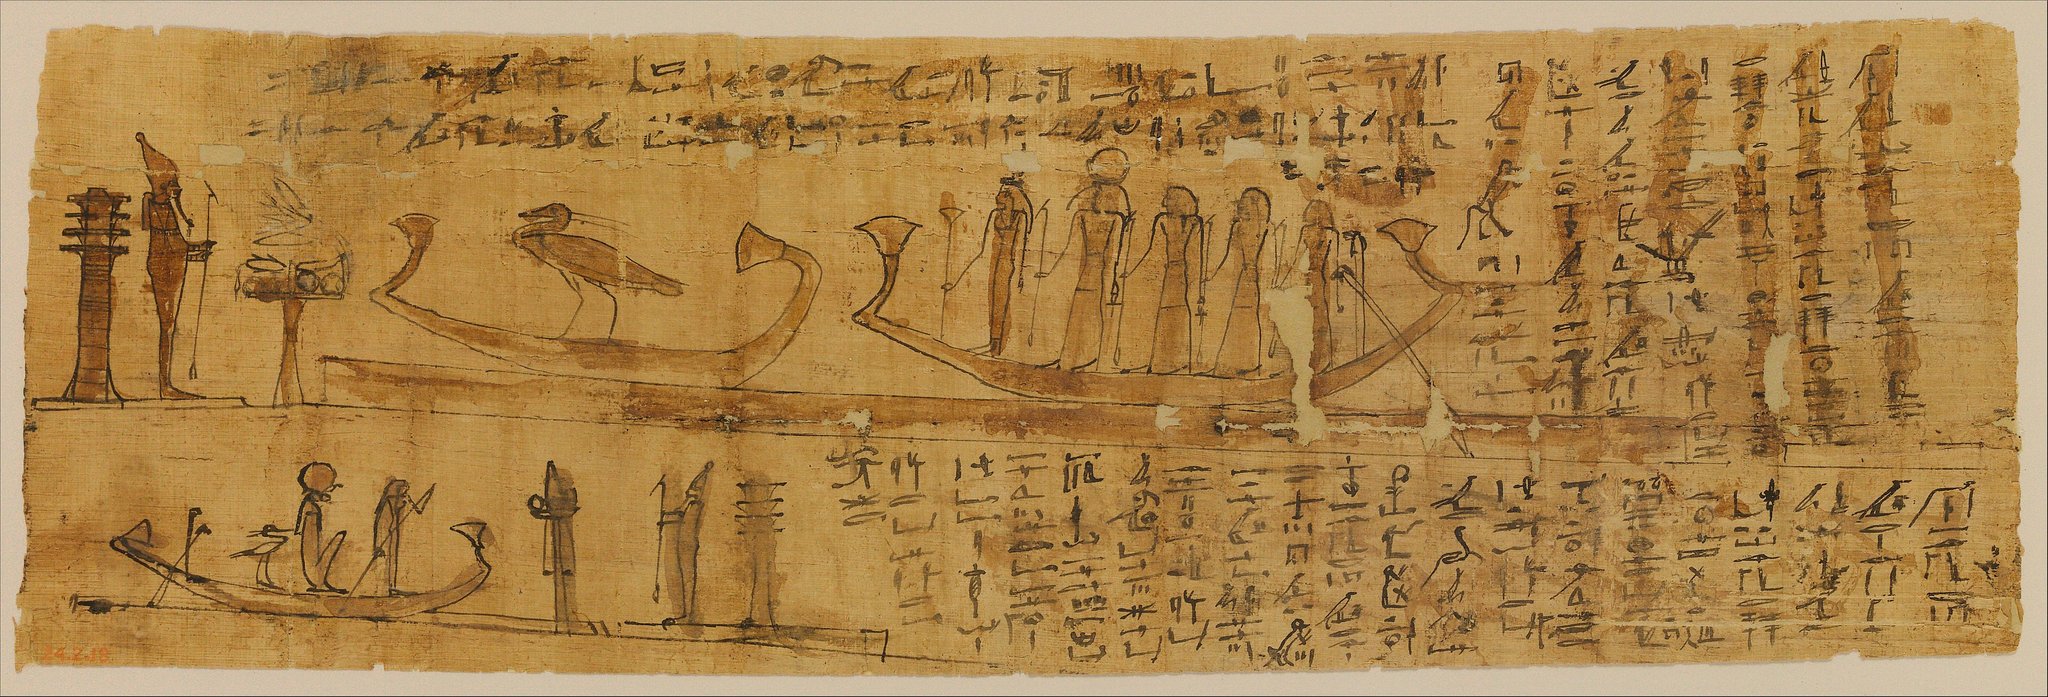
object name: papyrus, funerary, book of the dead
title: Book of the Dead Papyrus with Chapters 100 and 129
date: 664-630 BCE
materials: ink, paint, papyrus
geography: southern upper egypt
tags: human figures,birds,hieroglyphs,boats